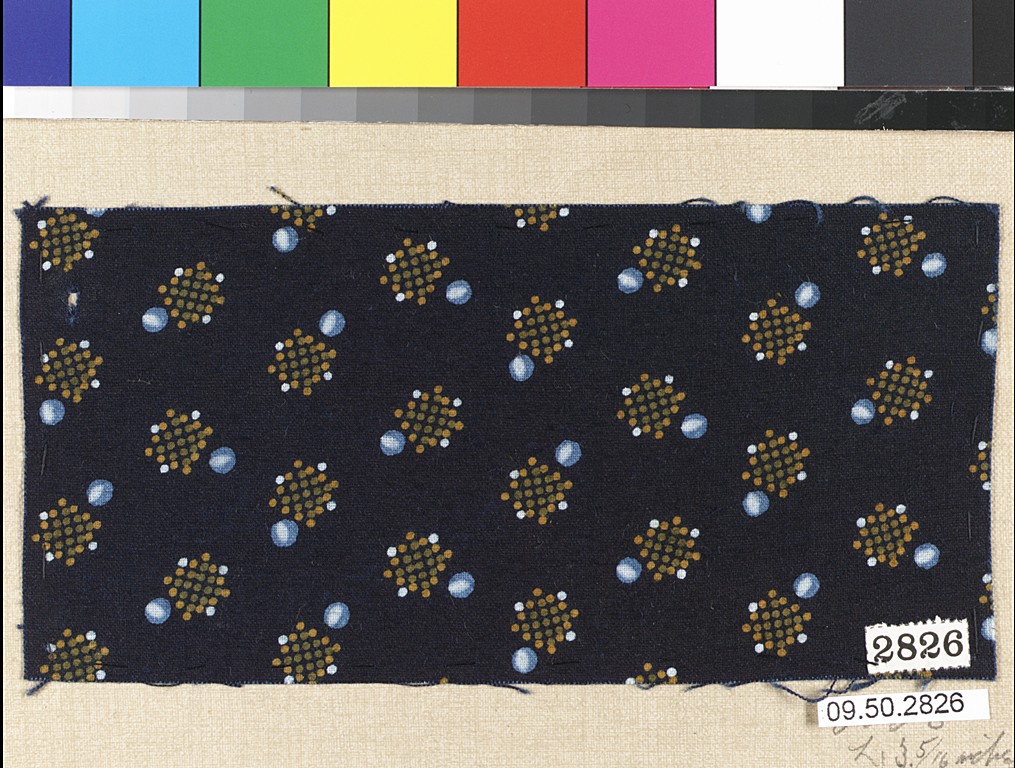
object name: piece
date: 1801-1900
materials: cotton